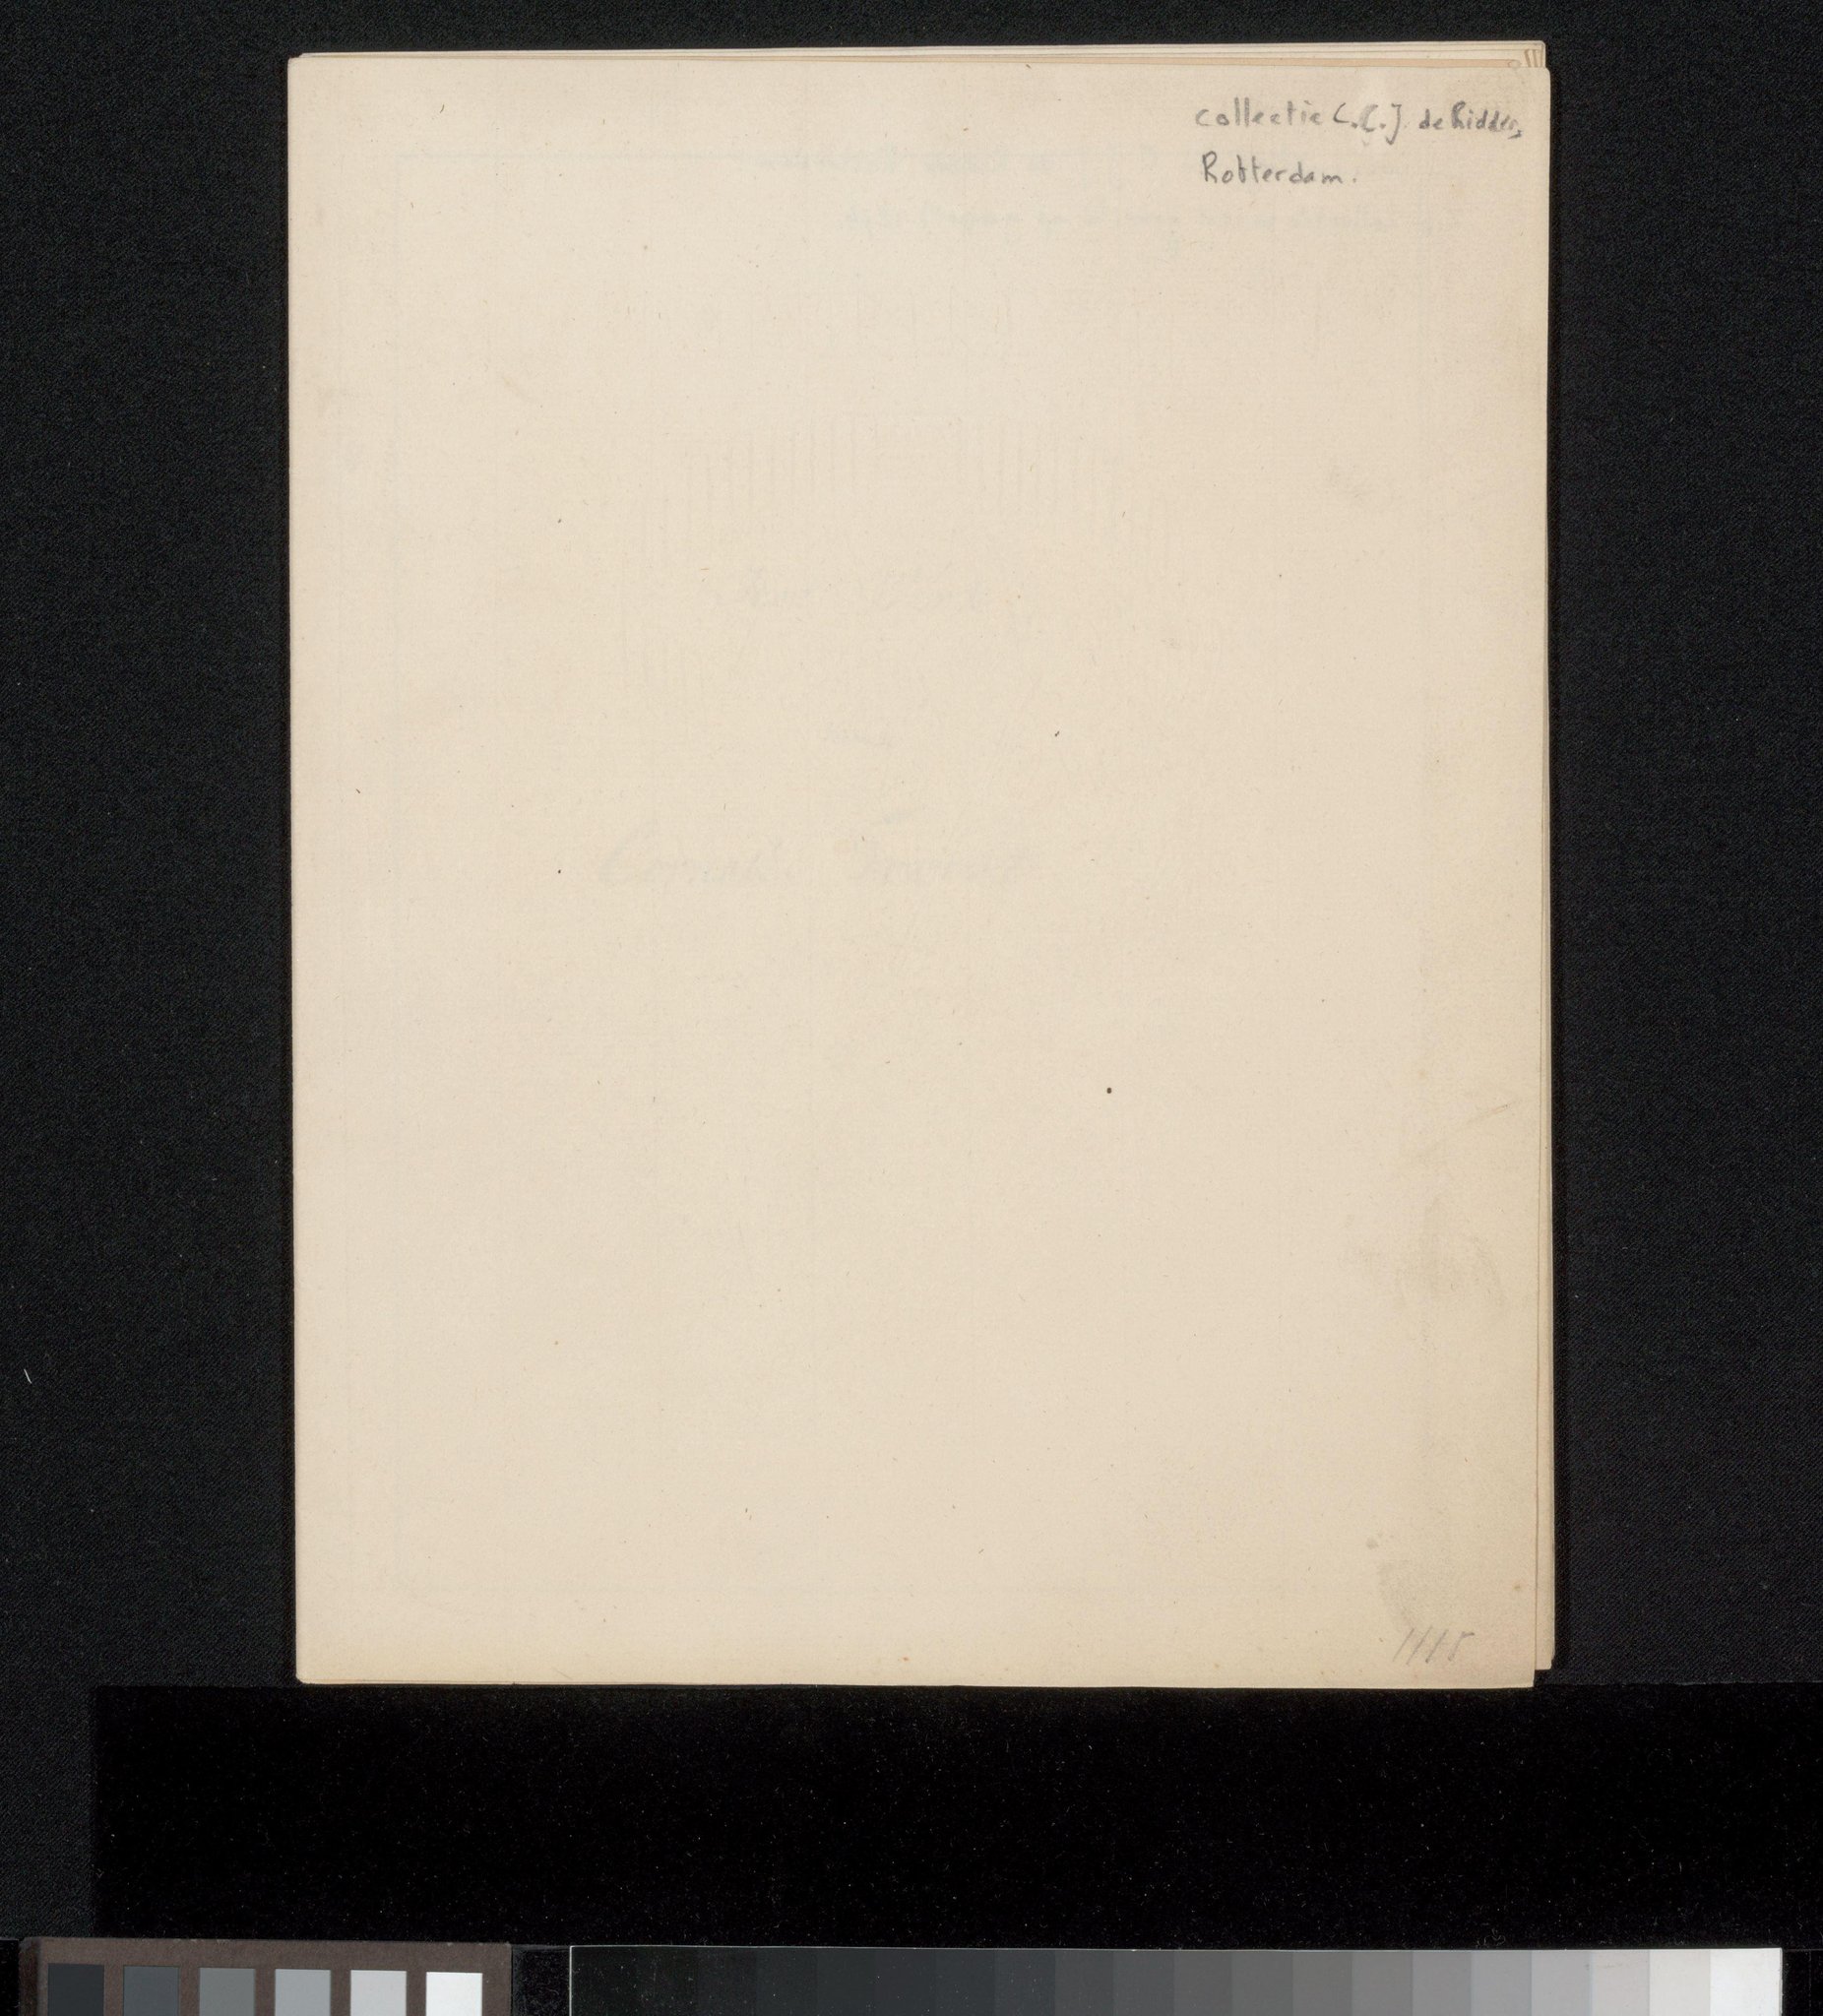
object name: document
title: Lijst van tekeningen van Cornelis Troost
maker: Anonymous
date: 1850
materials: ink, paper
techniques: writing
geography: netherlands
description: Lijst van tekeningen van Cornelis Troost en van prenten naar Troost, collectie C.C.J. de Ridder (Rotterdam). De collectie van De Ridder is geveild op 9 april 1874.